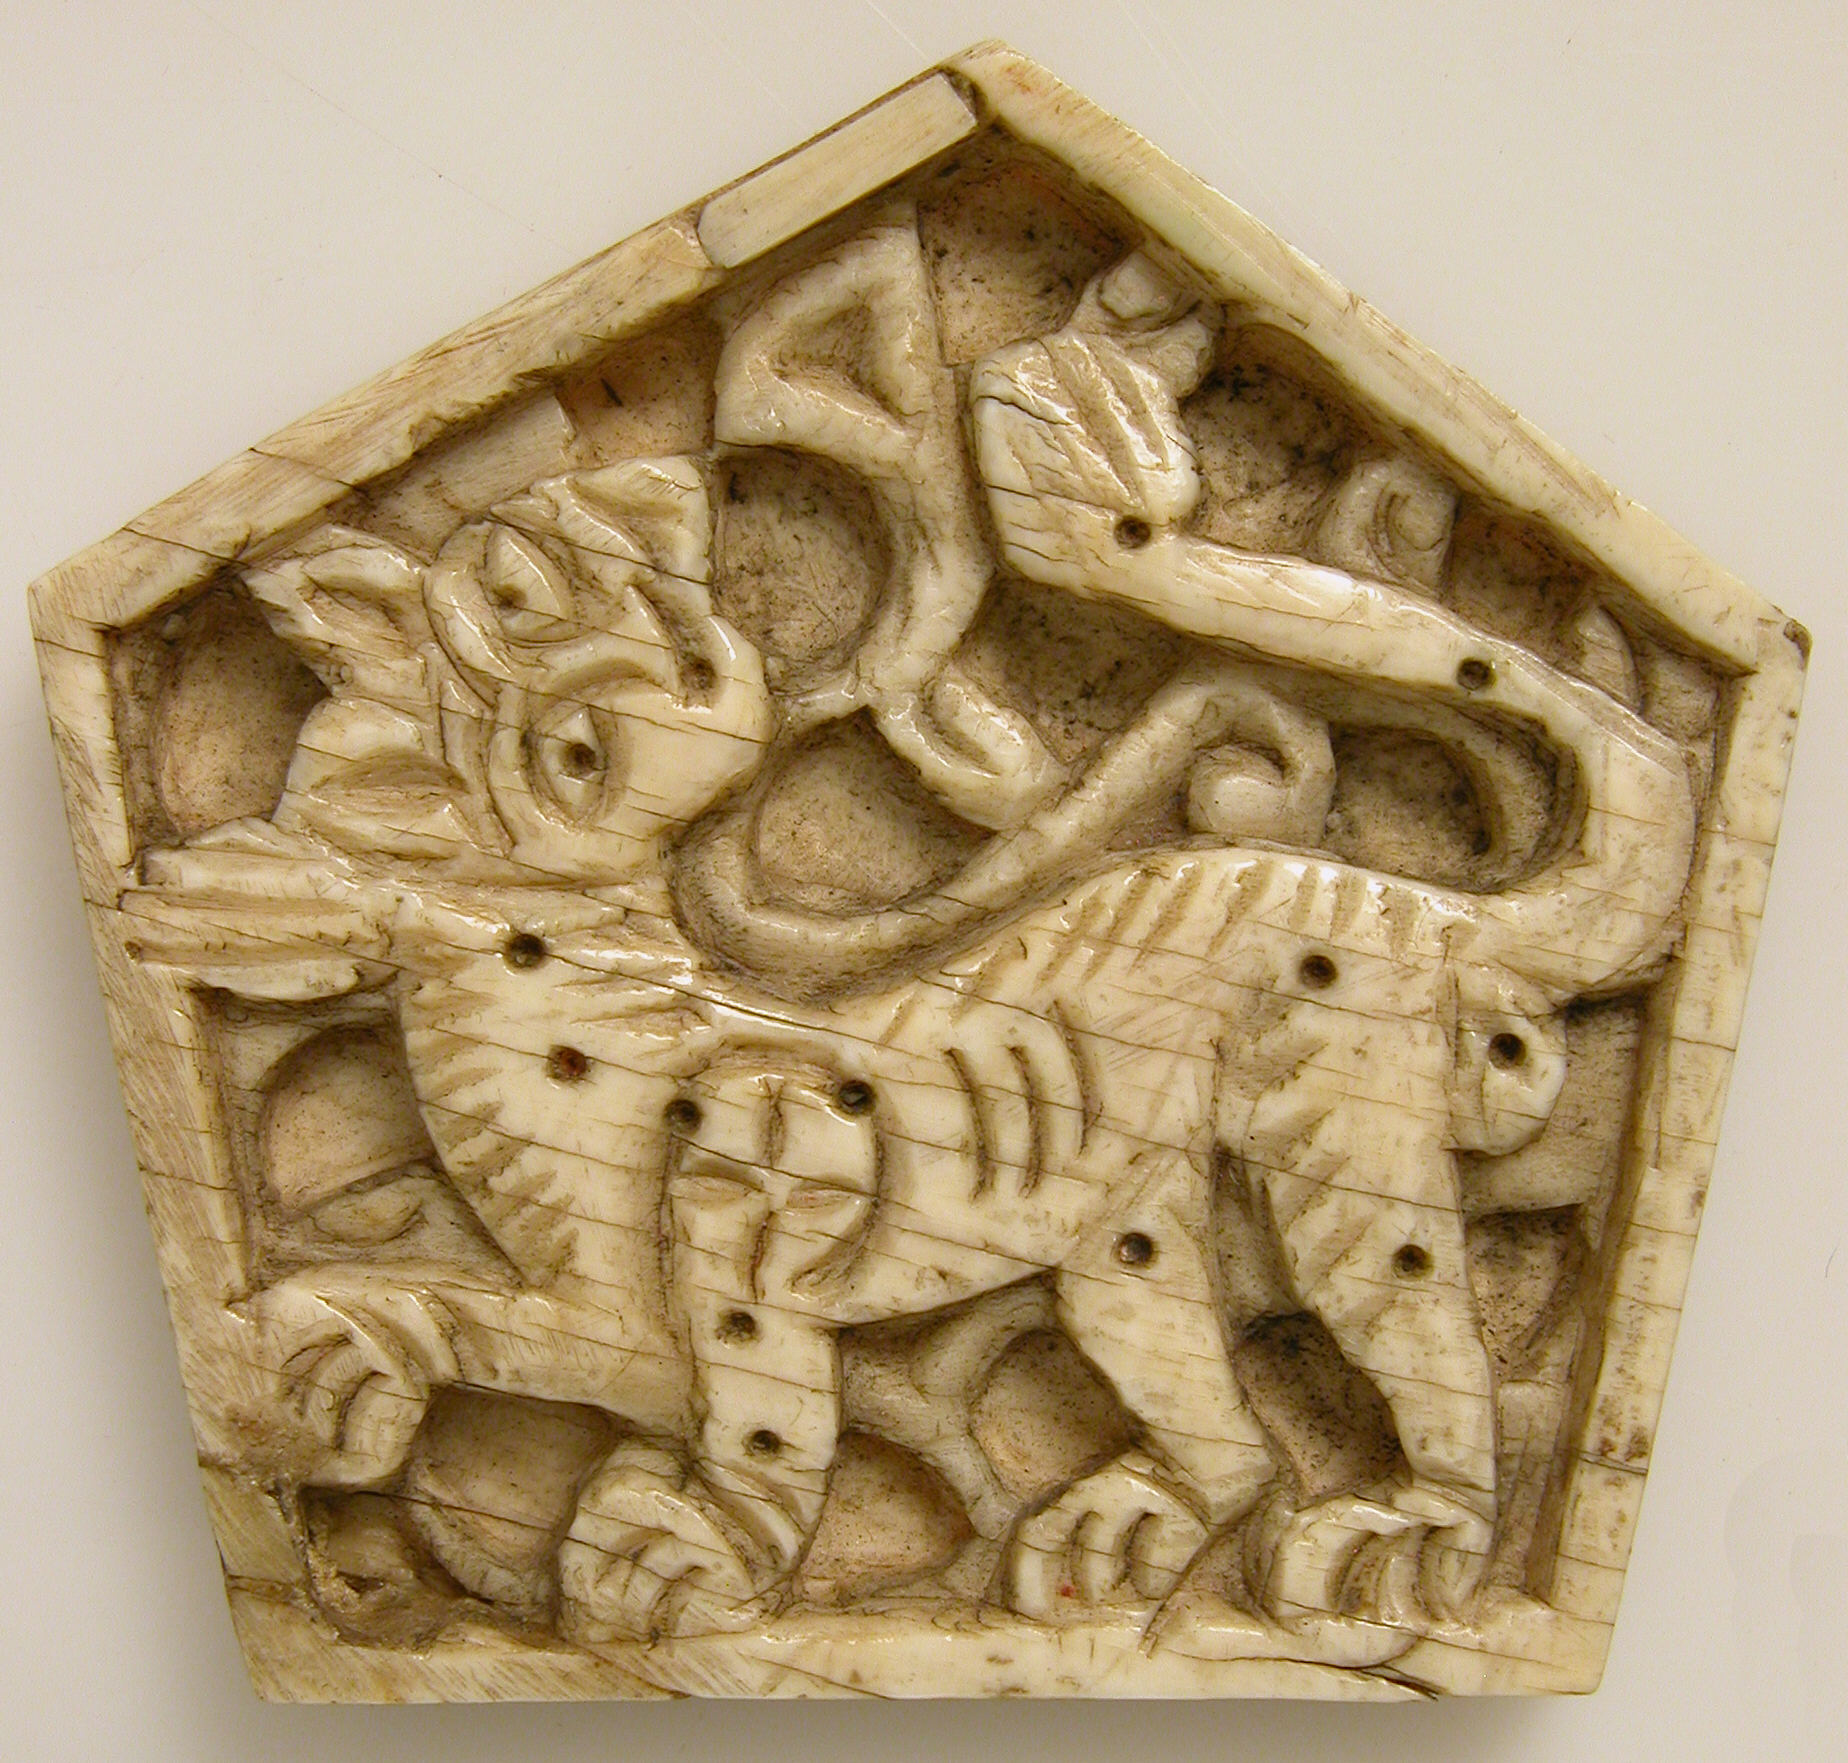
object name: plaque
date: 1101-1200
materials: bone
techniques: carving, incising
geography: italy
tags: lions